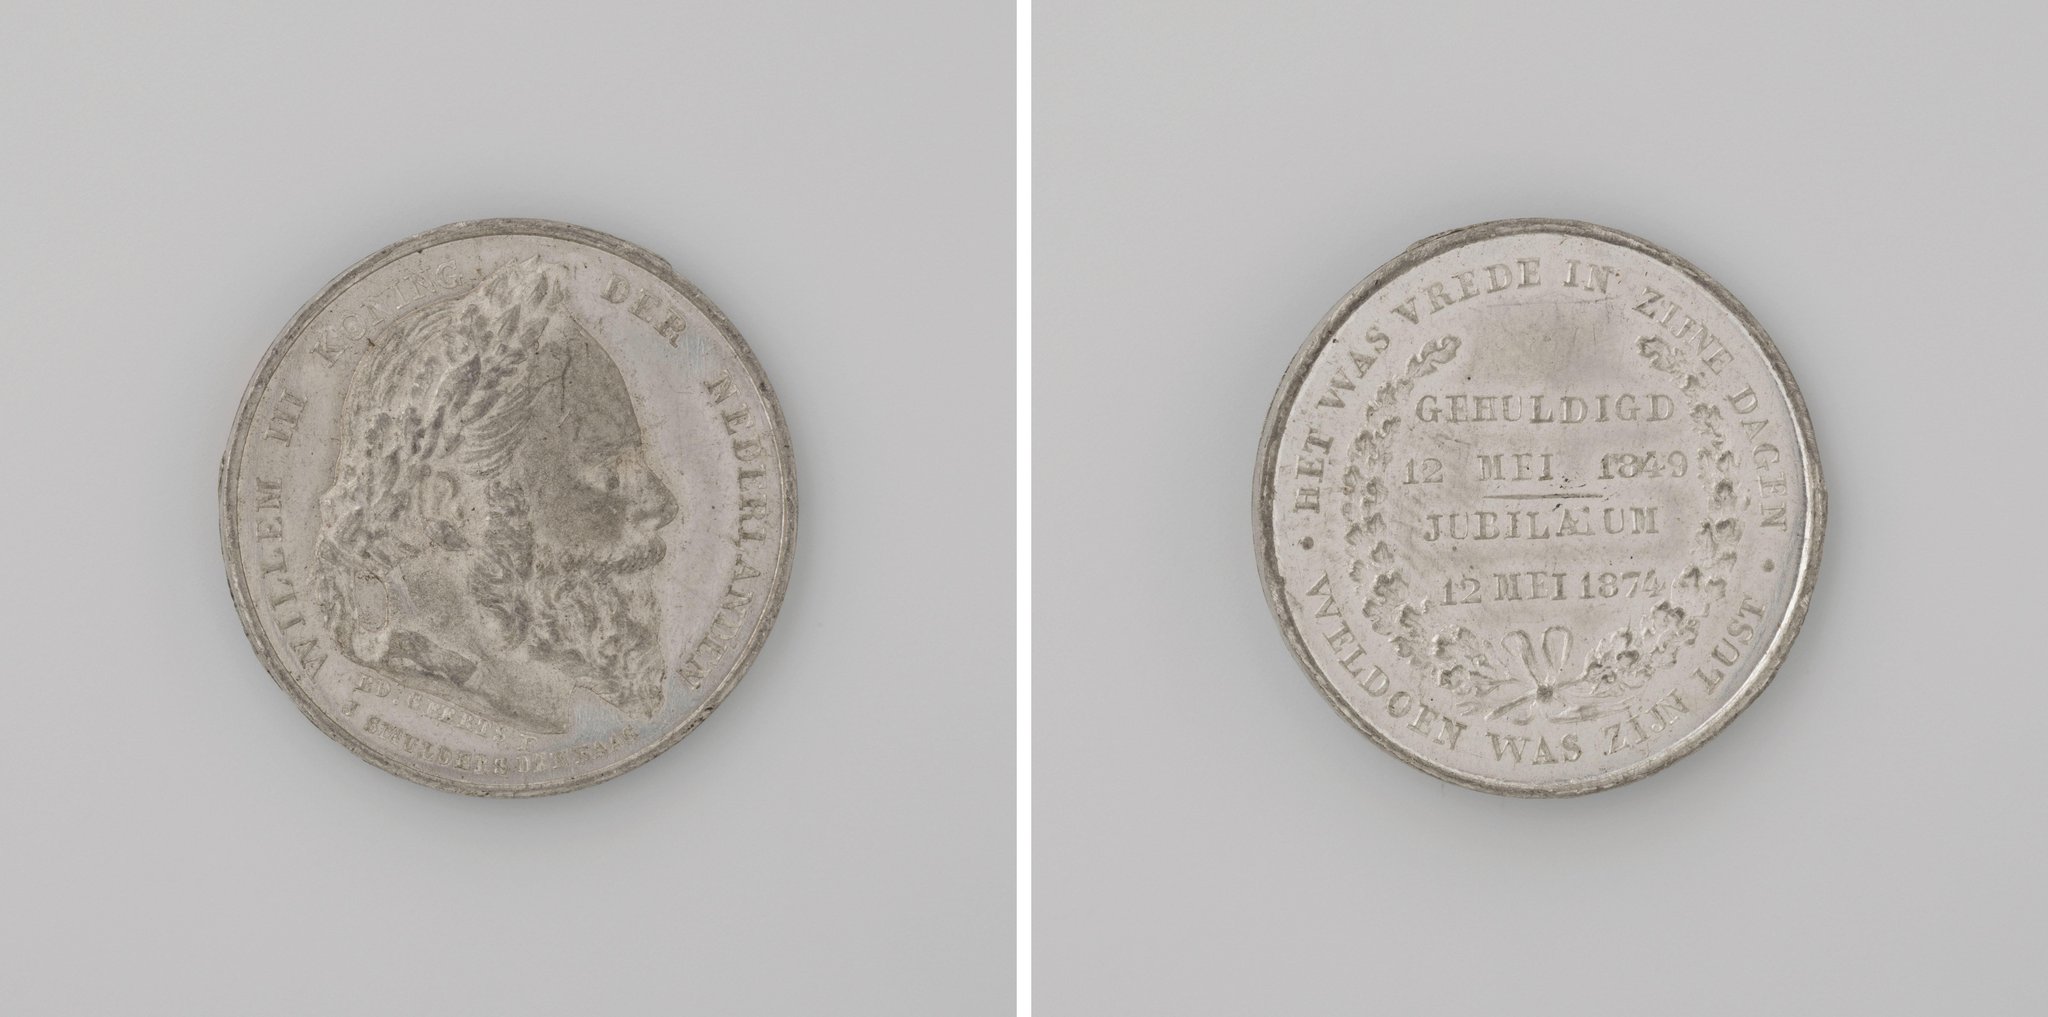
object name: history medal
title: Vijfentwintigjarig regeringsjubileum van Koning Willem III 1874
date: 1874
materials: aluminum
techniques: striking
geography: the hague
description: Tinnen penning, op de voorzijde het bekranste portret van Willem III naar rechts met omschrift, op de keerzijde vier regels tekst tussen samengestrikte eikentakken, met omschrift.